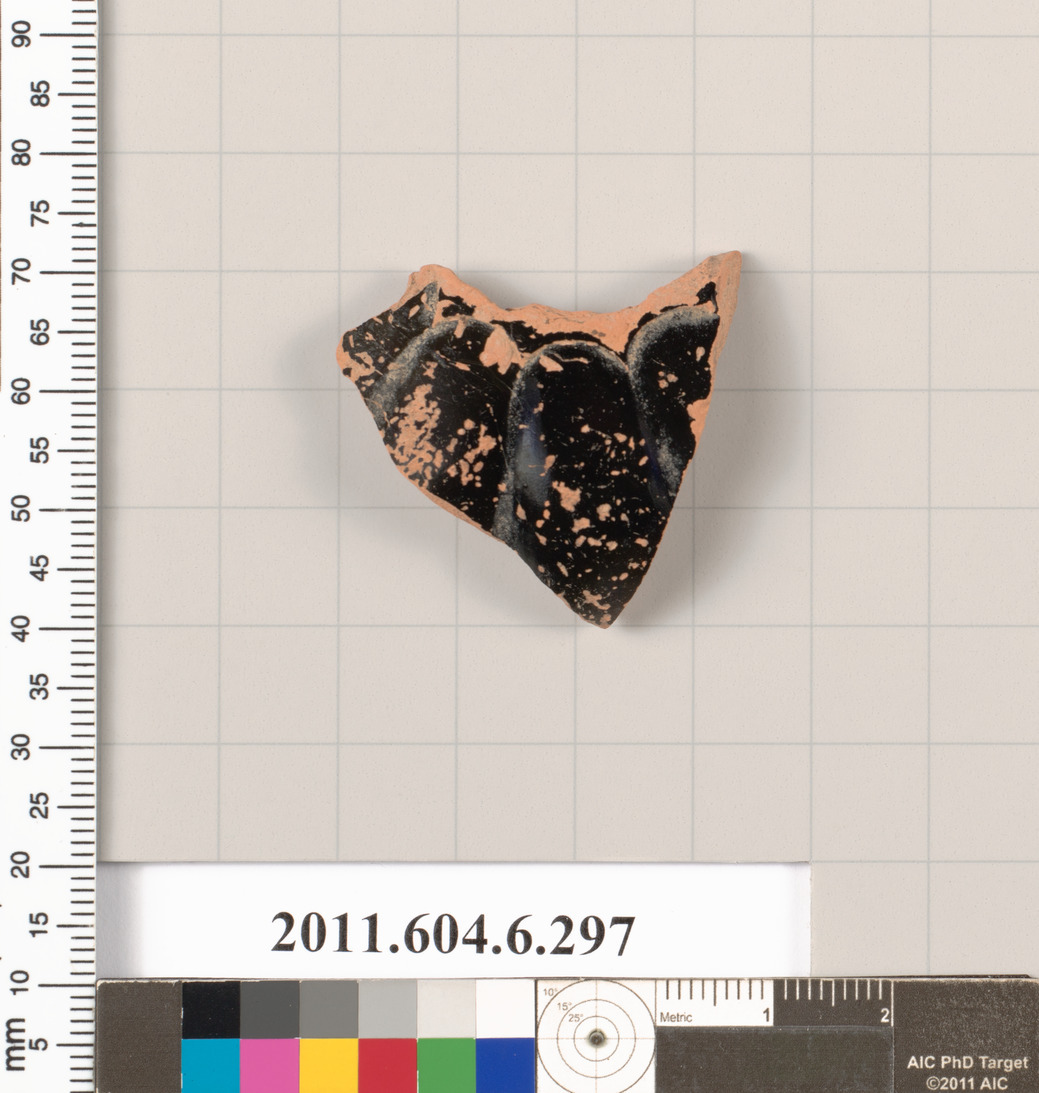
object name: undetermined closed shape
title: Terracotta fragment of a closed shape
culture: greek, attic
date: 400-301 BCE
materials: terracotta